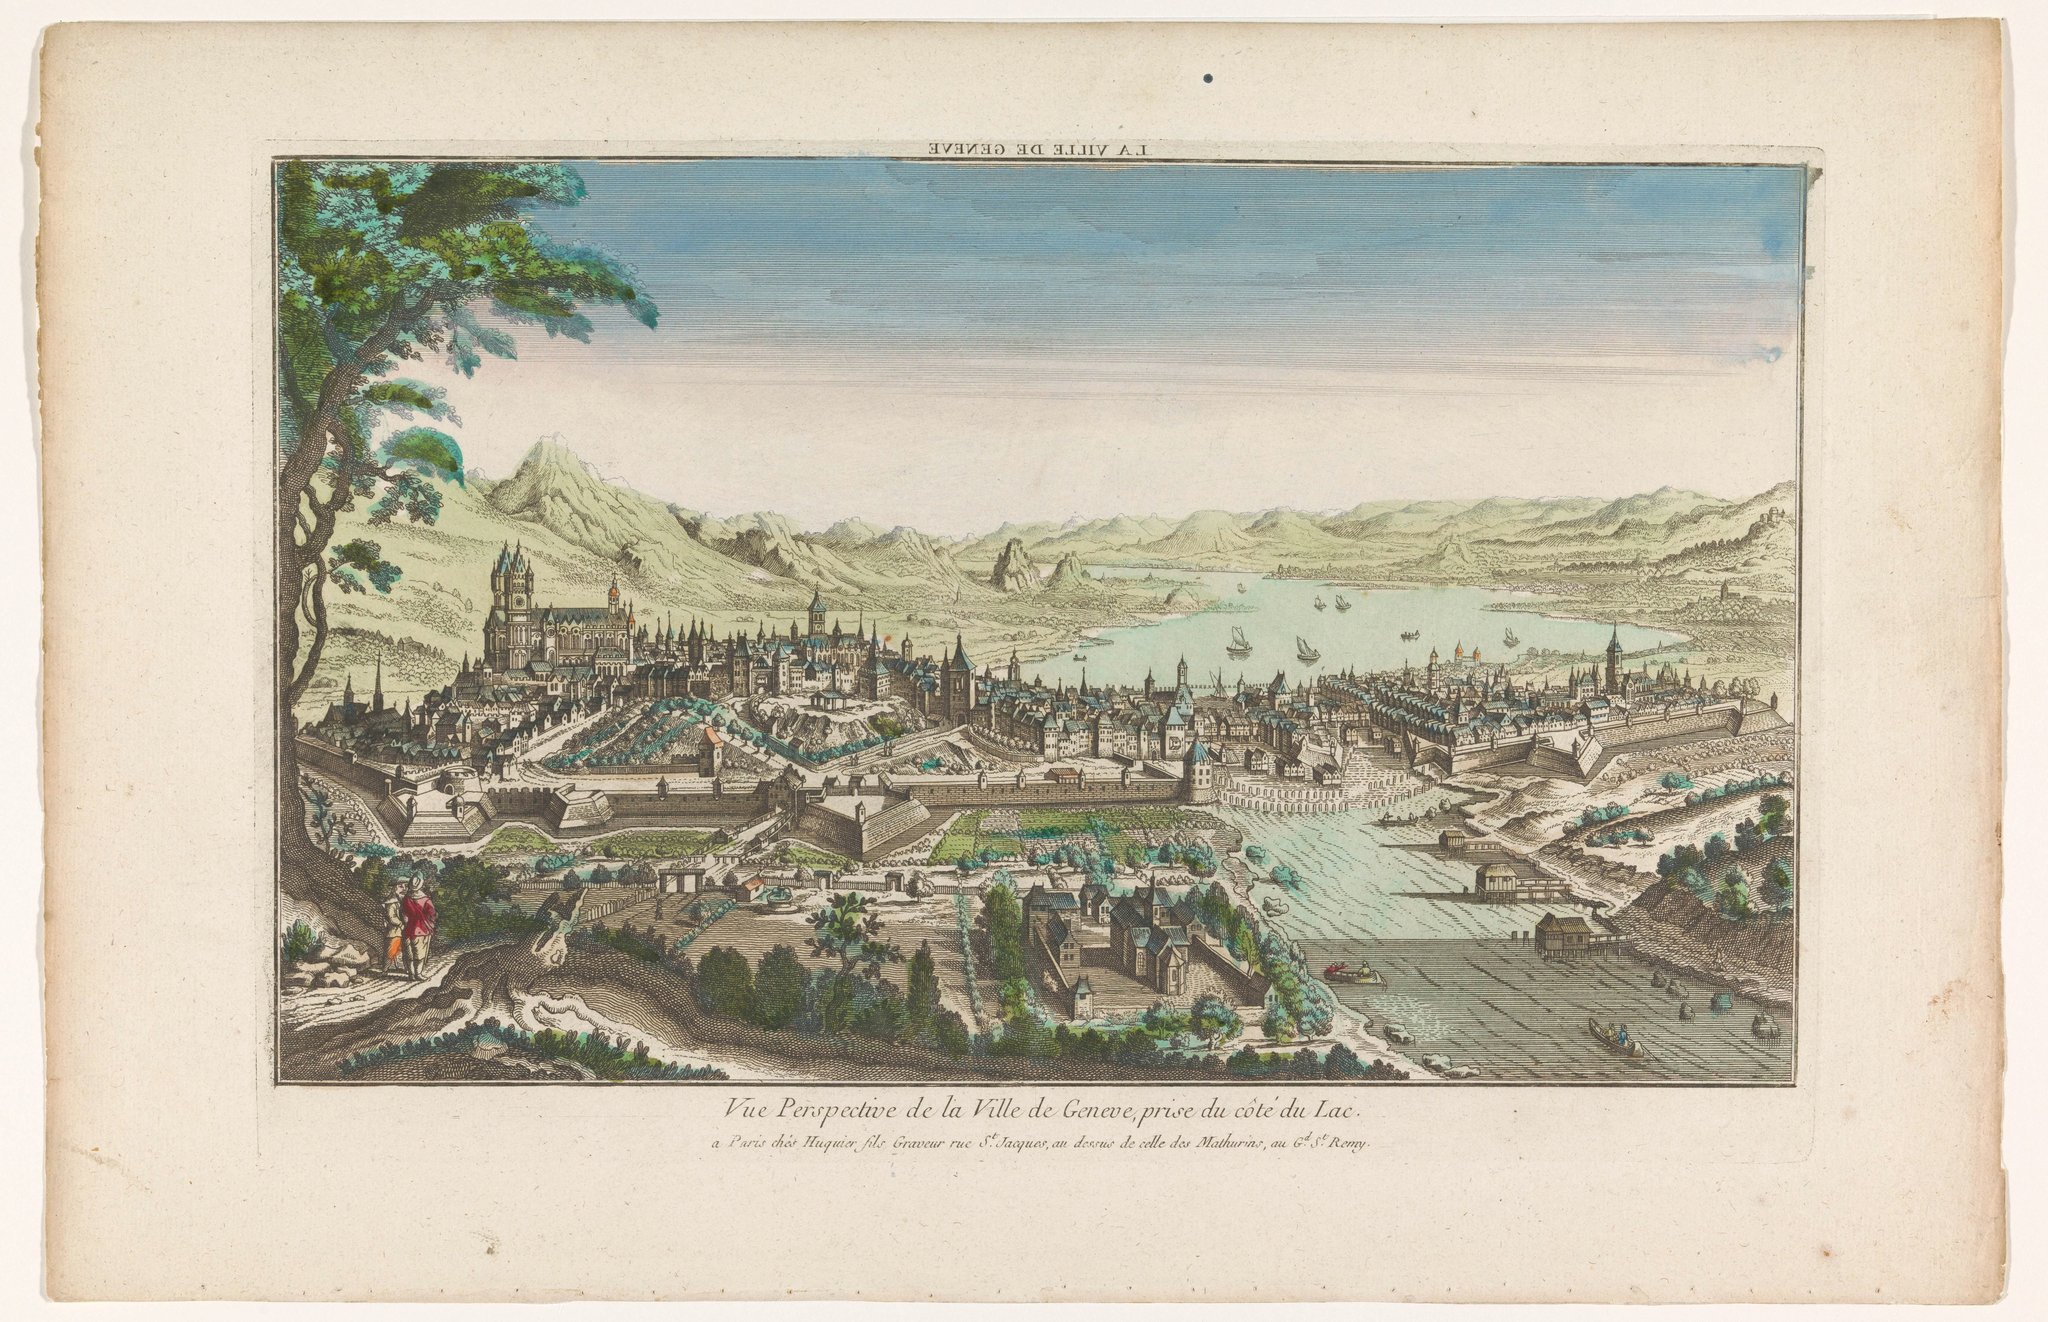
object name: print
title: Gezicht op de stad Genève gezien vanaf het Meer van Genève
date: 1735-1805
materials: paper, watercolor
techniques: brush, etching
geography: paris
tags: sailing-ship, sailing-boat, church (exterior), city-view in general; 'veduta' (+ city(-scape) with figures, staffage), canals, waters (in city) (+ city(-scape) with figures, staffage)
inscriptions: collector's mark: Lugt 2166